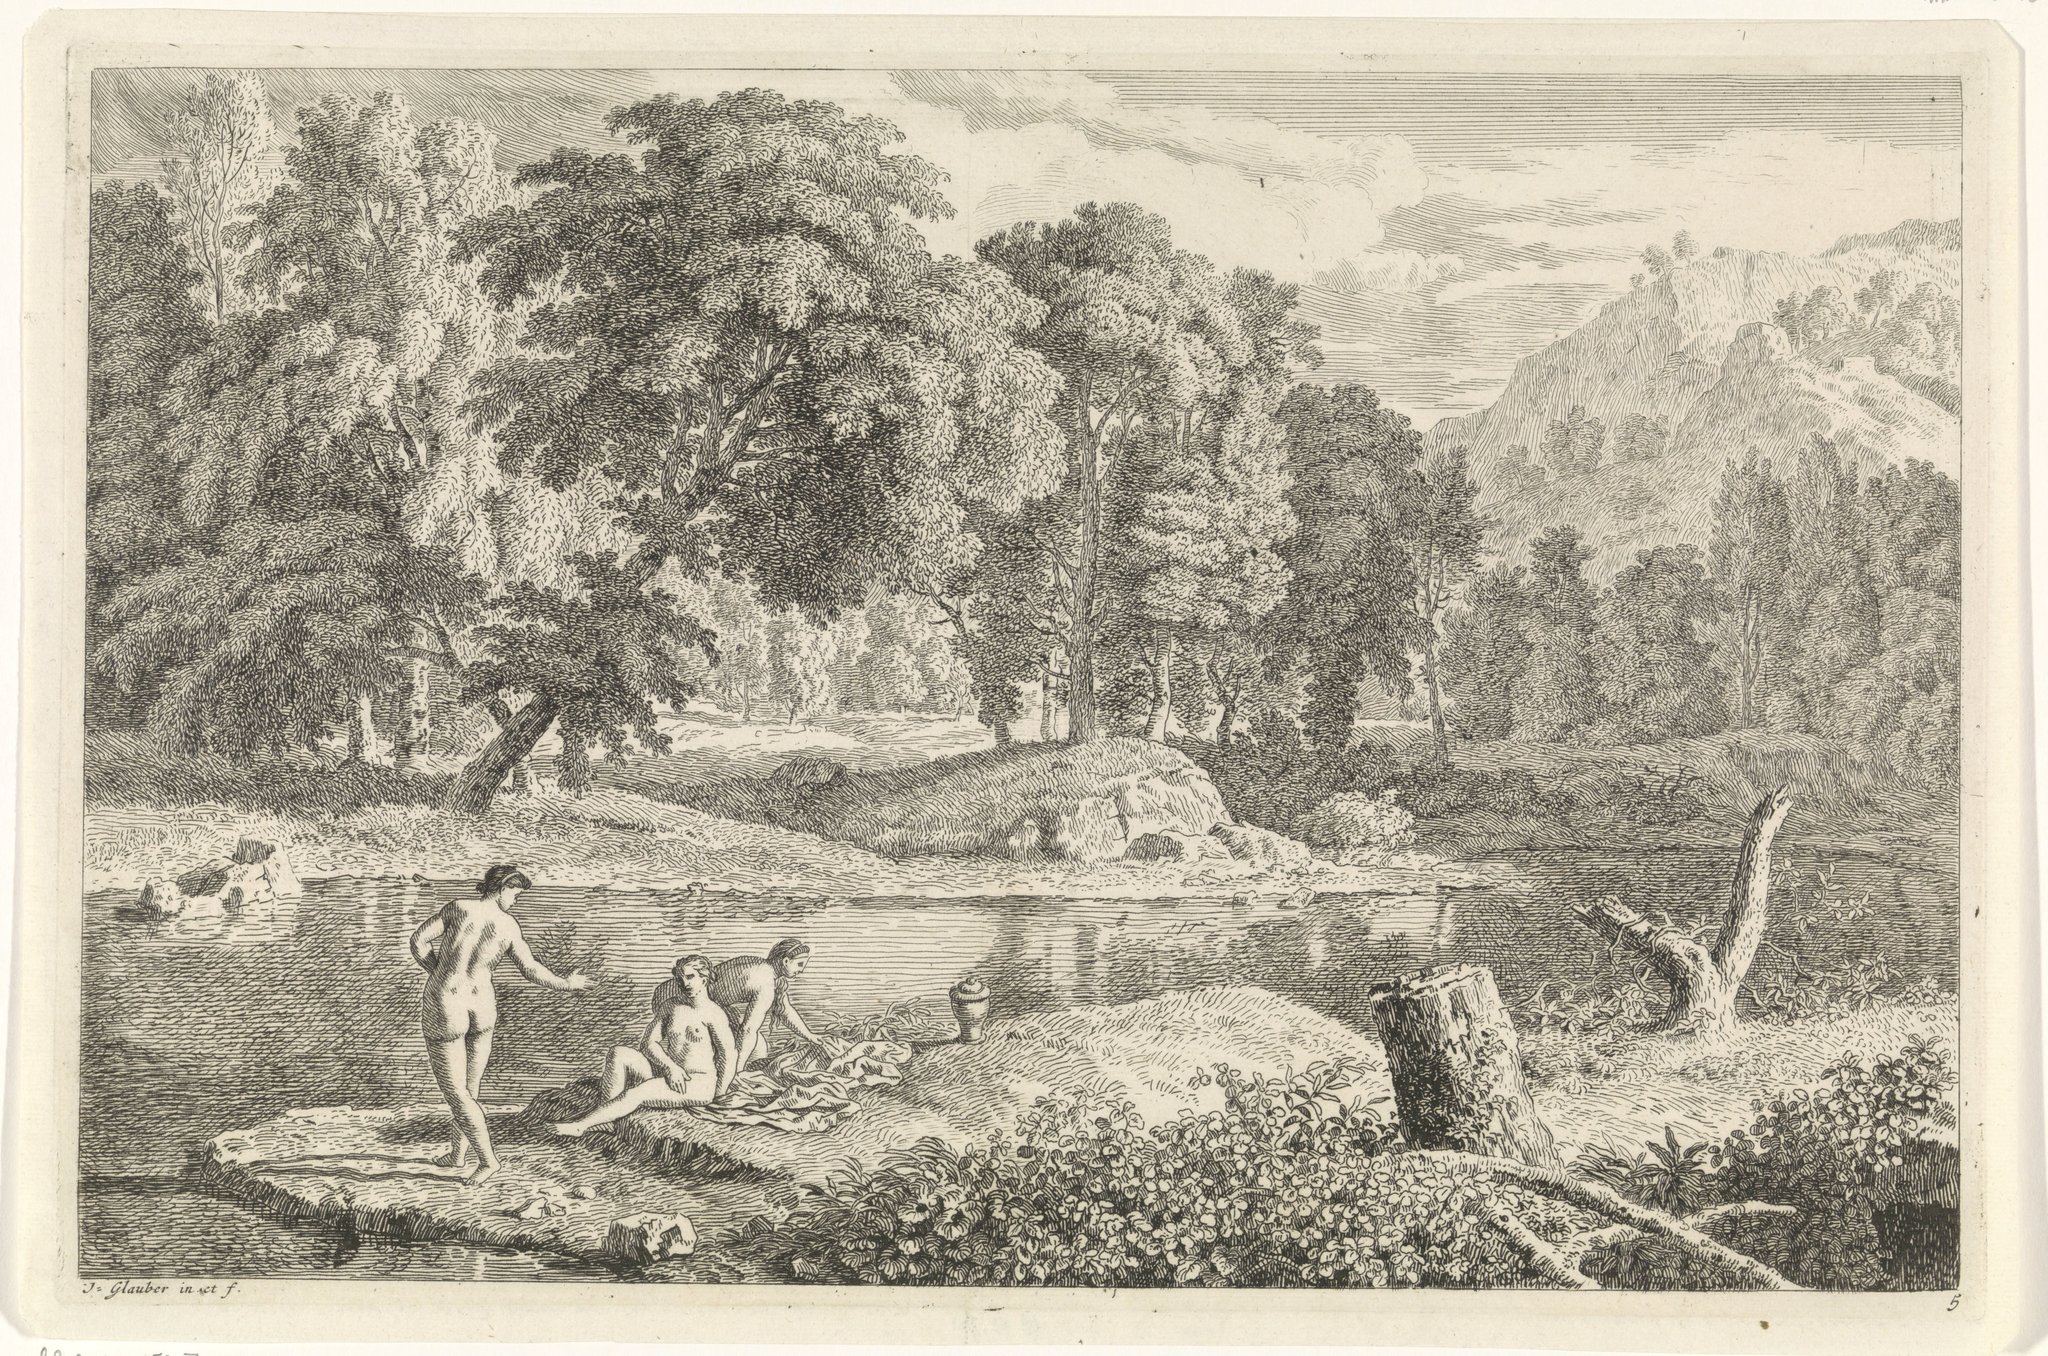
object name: print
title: Arcadisch landschap met een rivier en drie badende vrouwen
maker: johannes glauber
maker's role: draughtsman, painter, print maker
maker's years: 1646-1726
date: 1656-1726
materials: paper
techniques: etching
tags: taking a bath - aa - in the open air, river (+ landscape with figures, staffage), pastorals, arcadian scenes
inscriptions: collector's mark: Lugt 2228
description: Een arcadisch landschap met een rivier en drie badende vrouwen. De prent maakt deel uit van een serie met arcadische landschappen.